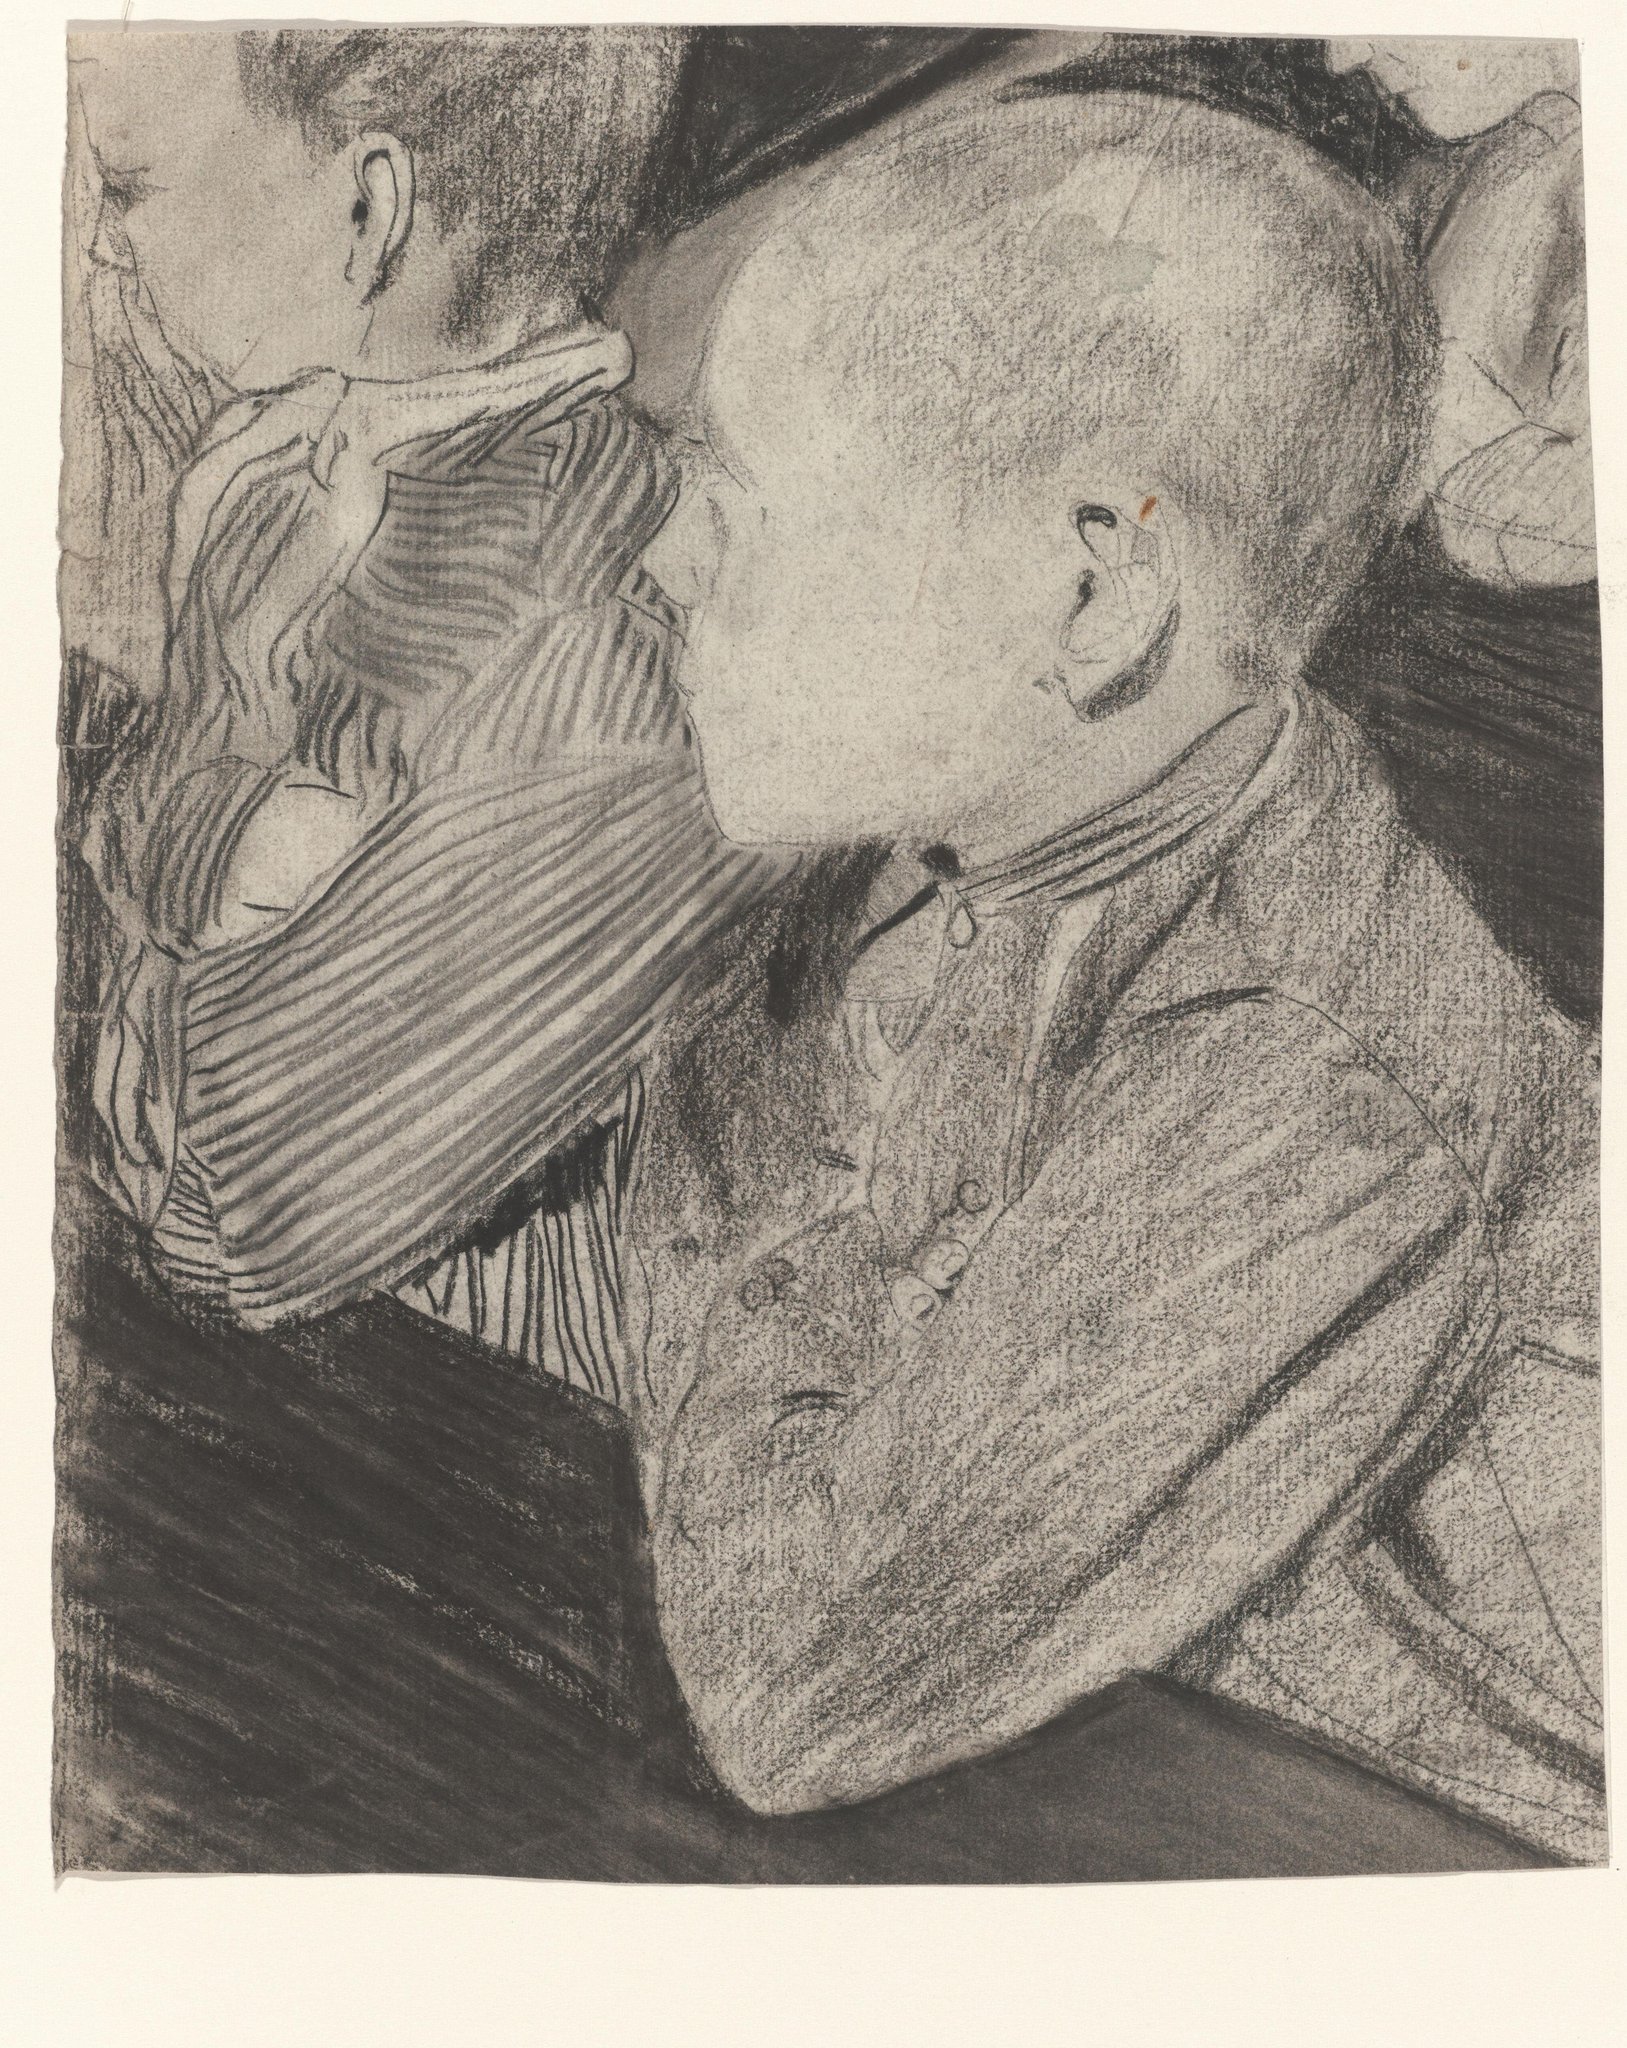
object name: drawing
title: Twee jongens in een schoolbank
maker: carel adolph lion cachet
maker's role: draughtsman, print maker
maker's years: 1864-1945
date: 1874-1945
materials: chalk, paper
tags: elementary school; class, form